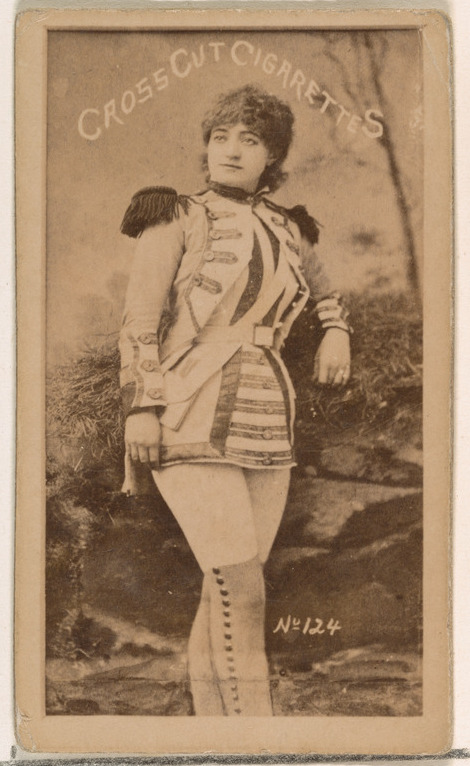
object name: print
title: Card Number 124, from the Actors and Actresses series (N145-1) issued by Duke Sons & Co. to promote Cross Cut Cigarettes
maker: w. duke, sons & co.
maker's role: publisher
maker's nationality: american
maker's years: 1870-1920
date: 1880-1889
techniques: albumen silver print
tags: portraits,women,actresses